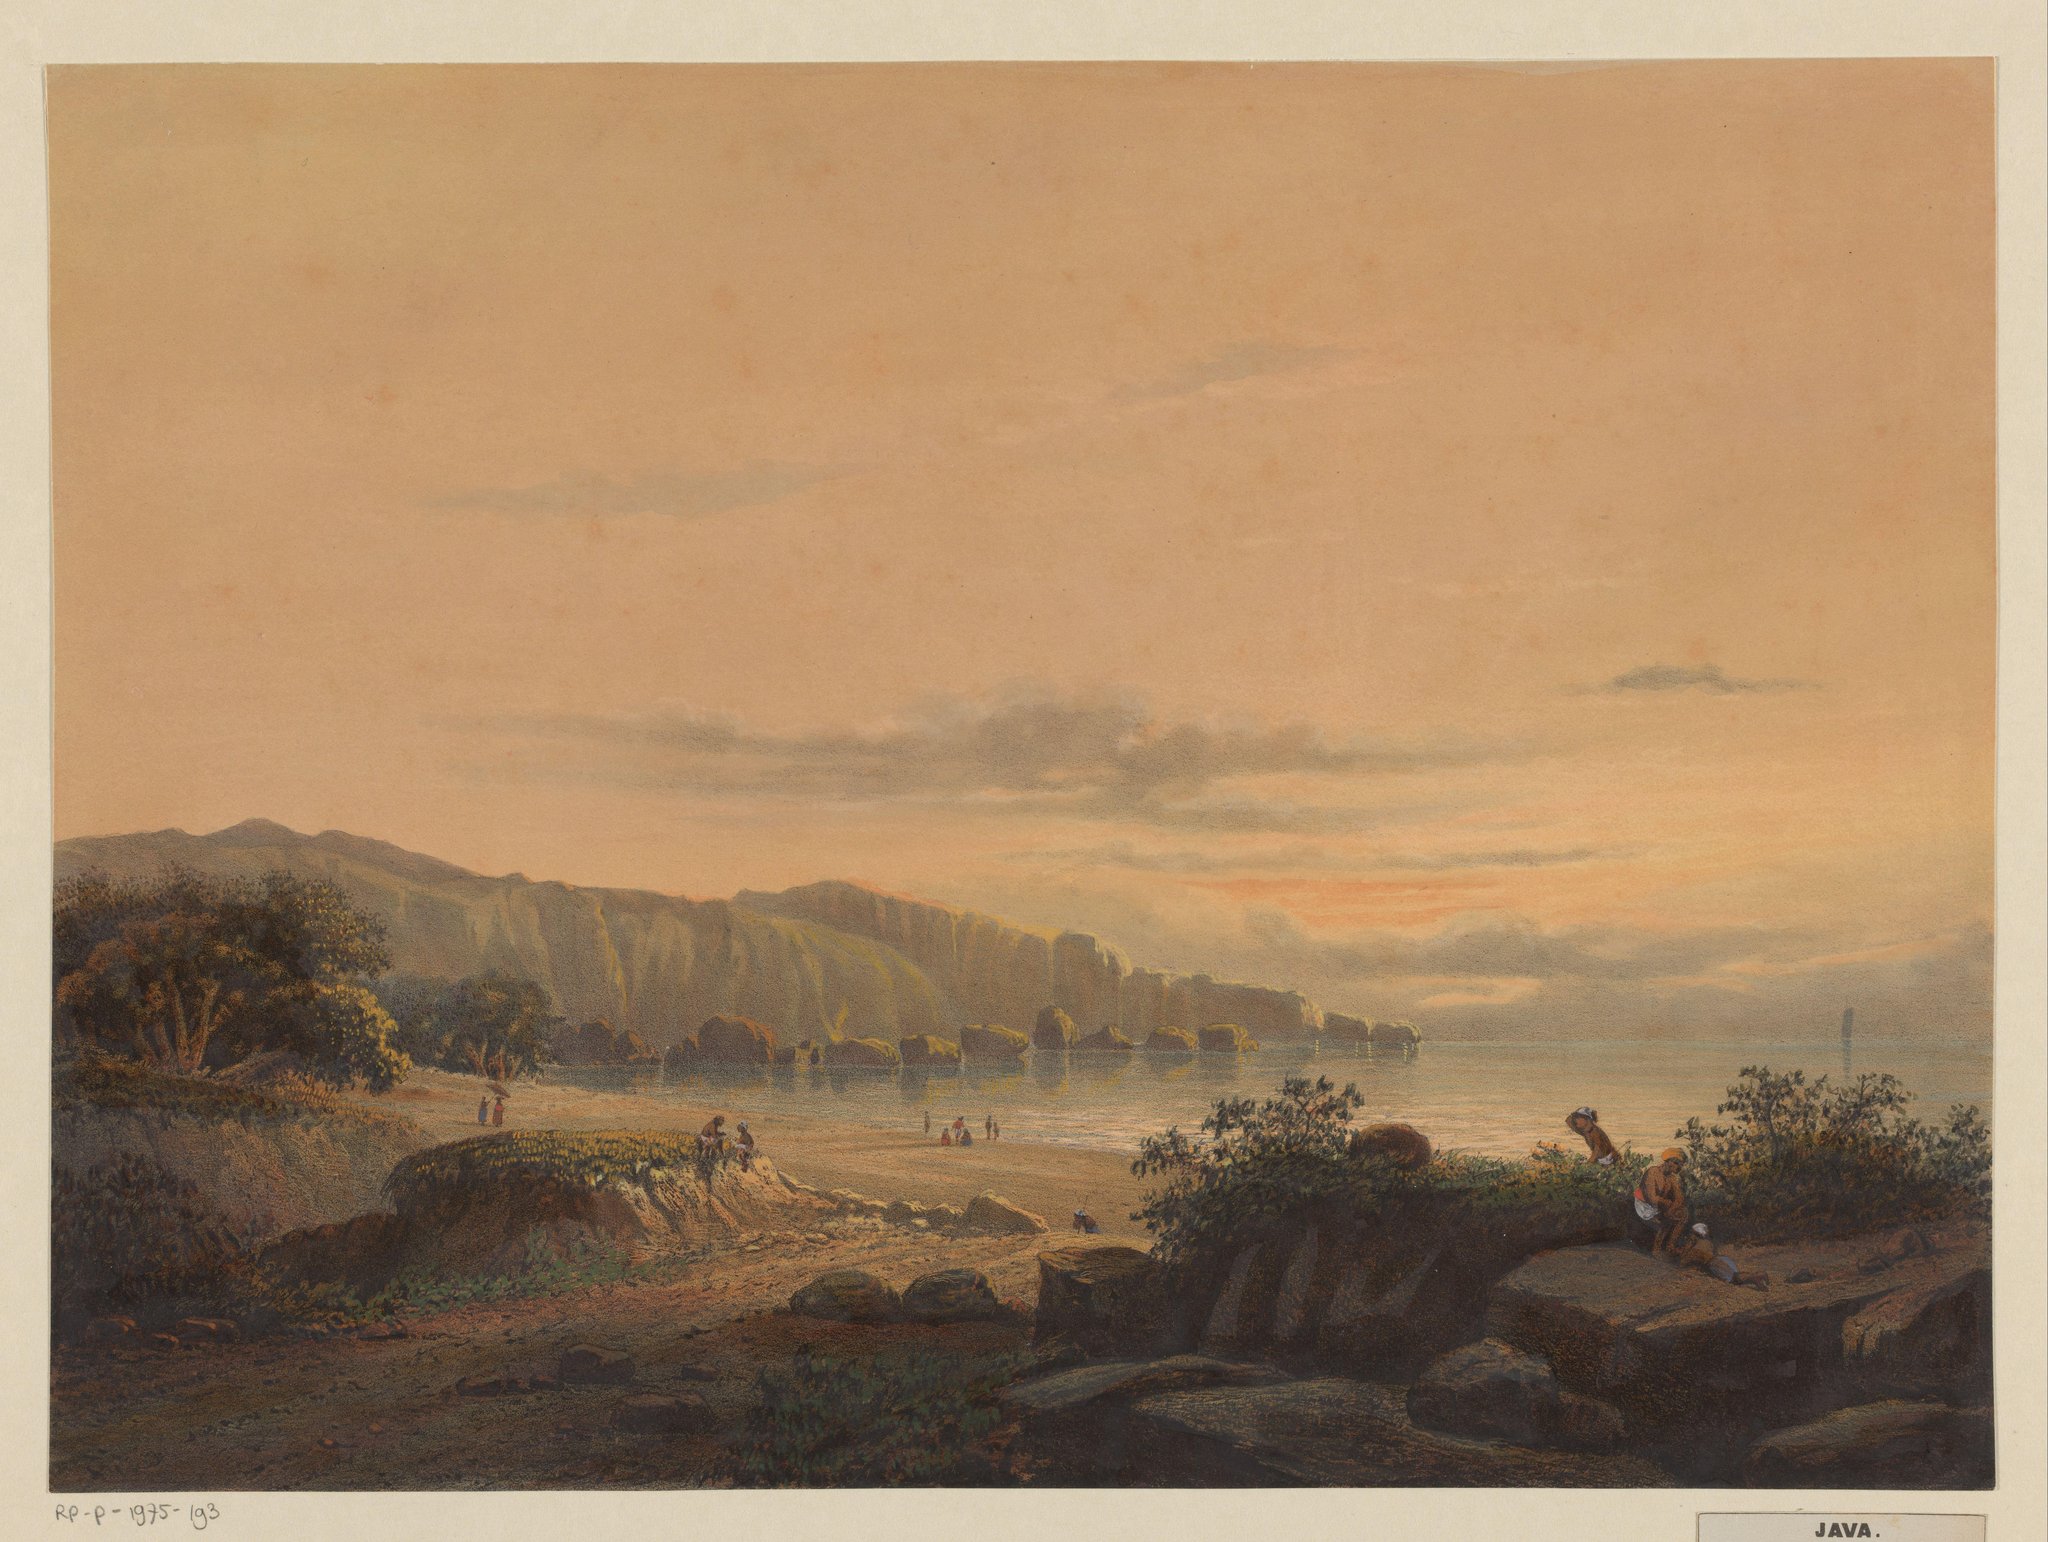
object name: print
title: Gezicht op een baai op Java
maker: johan conrad greive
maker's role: draughtsman, painter, print maker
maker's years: 1837-1891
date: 1869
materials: paper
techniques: lithograph, hand coloring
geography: dutch east indies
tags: gulf, bay (+ landscape with figures, staffage), landscapes in tropical and sub-tropical regions, java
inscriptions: collector's mark: Lugt 2228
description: De prent maakt deel uit van een omslag met een tekstblad en 24 losse prenten.